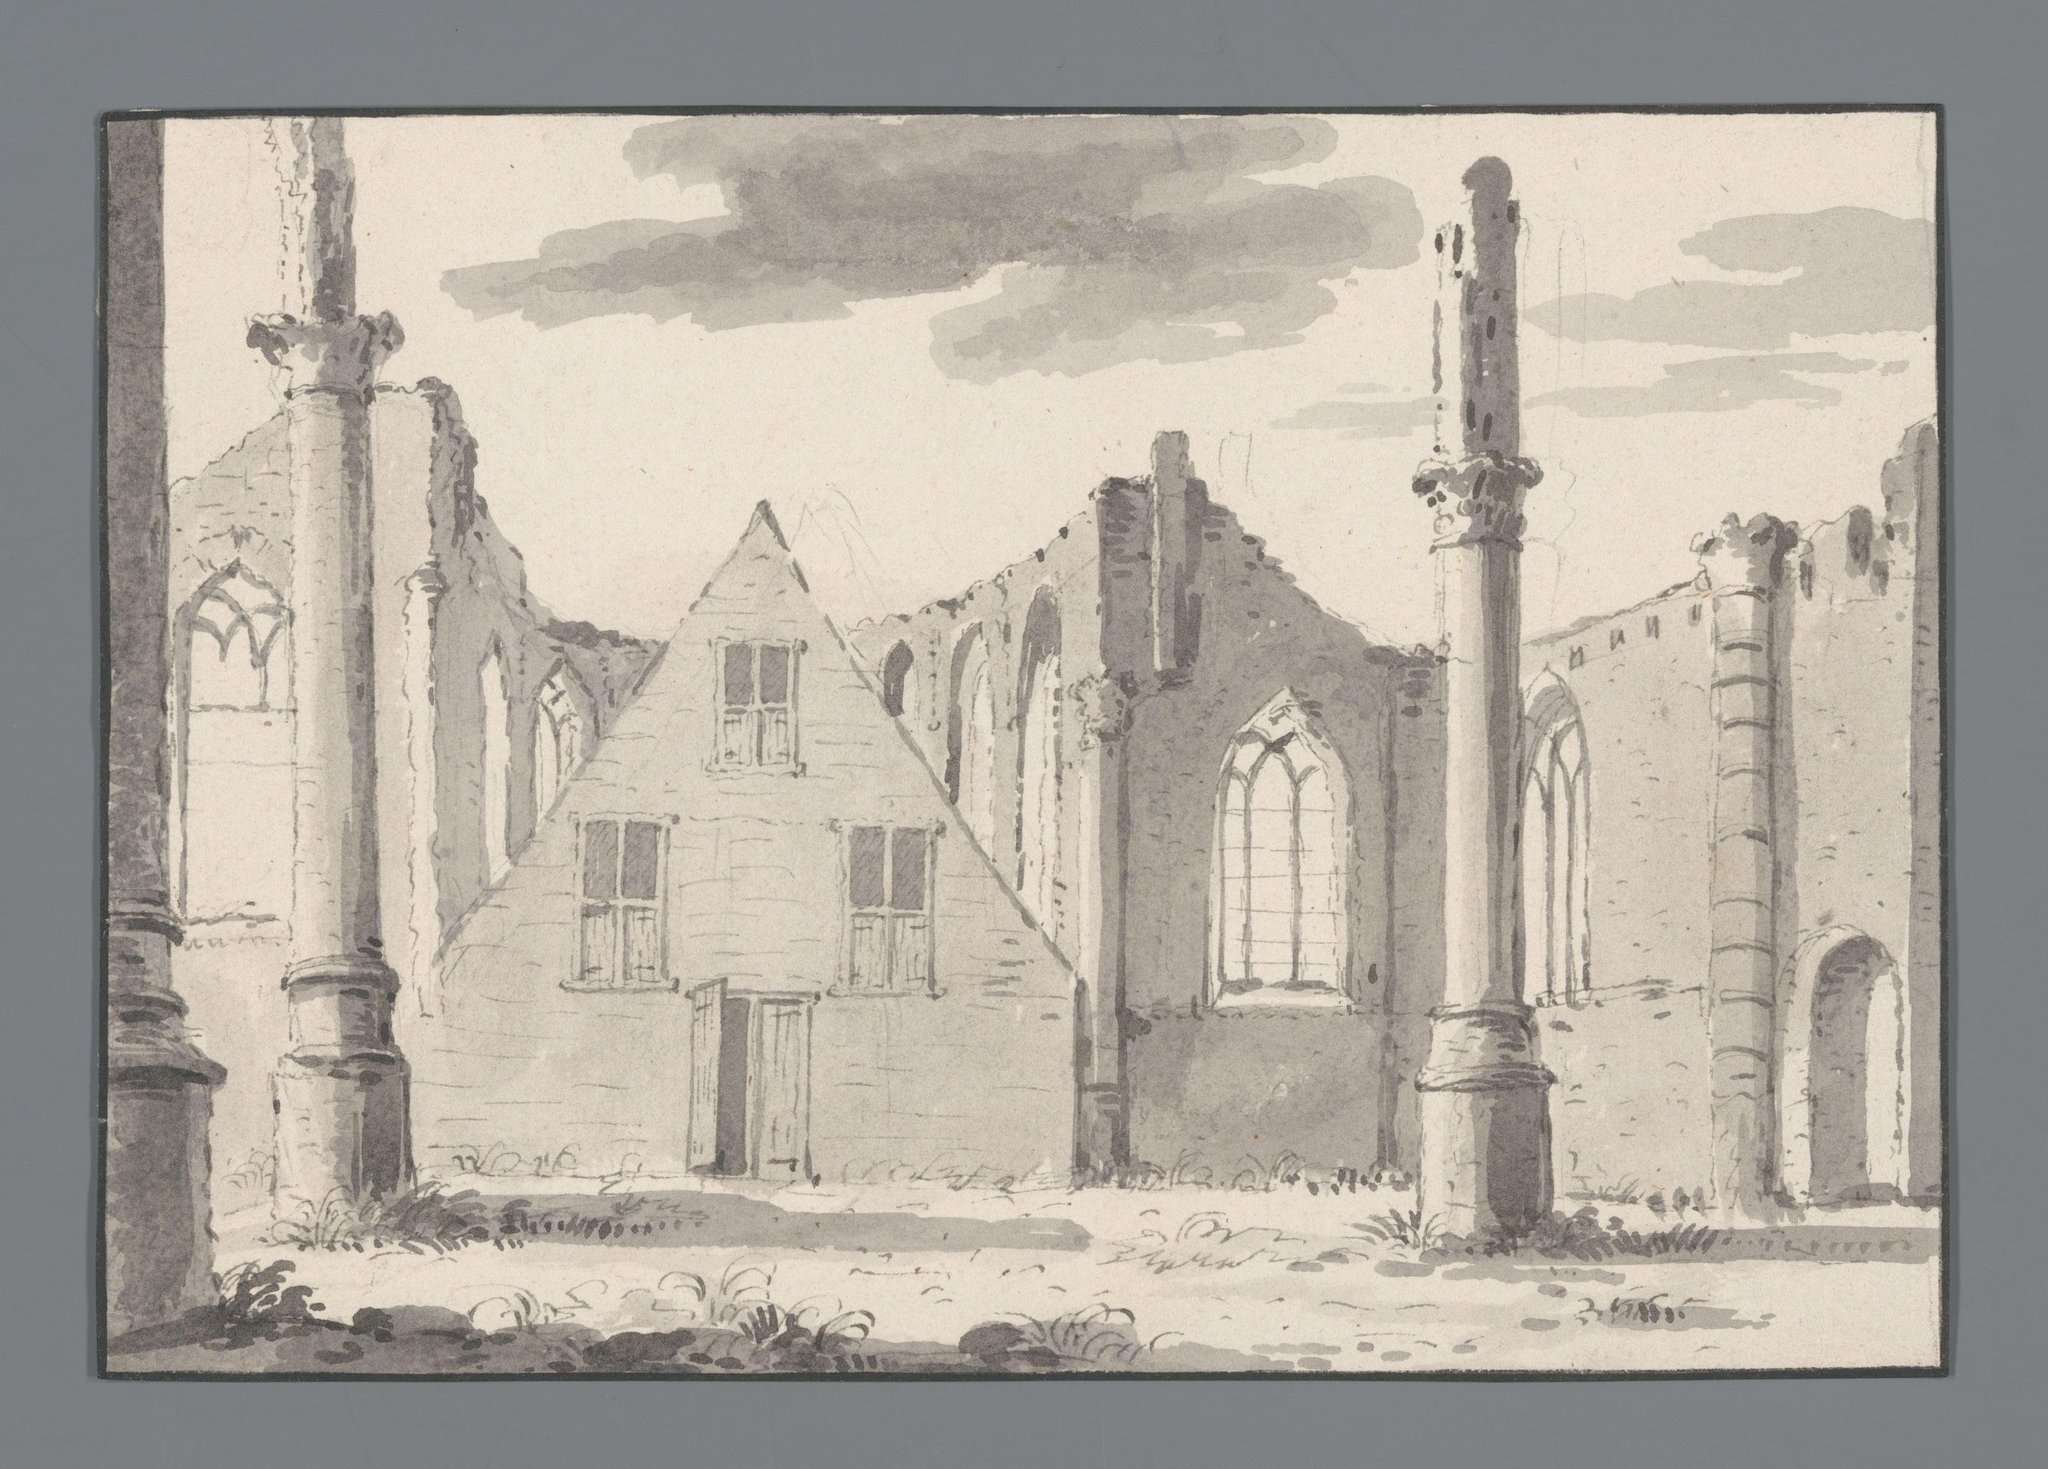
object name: drawing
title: Gezicht op de ruïne van het koor van de Sint-Maartens- of Grote Kerk in Tiel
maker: abraham rademaker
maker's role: draughtsman, print maker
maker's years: 1676-1735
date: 1725-1740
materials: ink, paper, pencil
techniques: brush, pen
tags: ruin of church, monastery, etc.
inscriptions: collector's mark: Lugt 2228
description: Mogelijk een kopie naar de prent van Abraham Rademaker, zie RP-P-2019-1816.